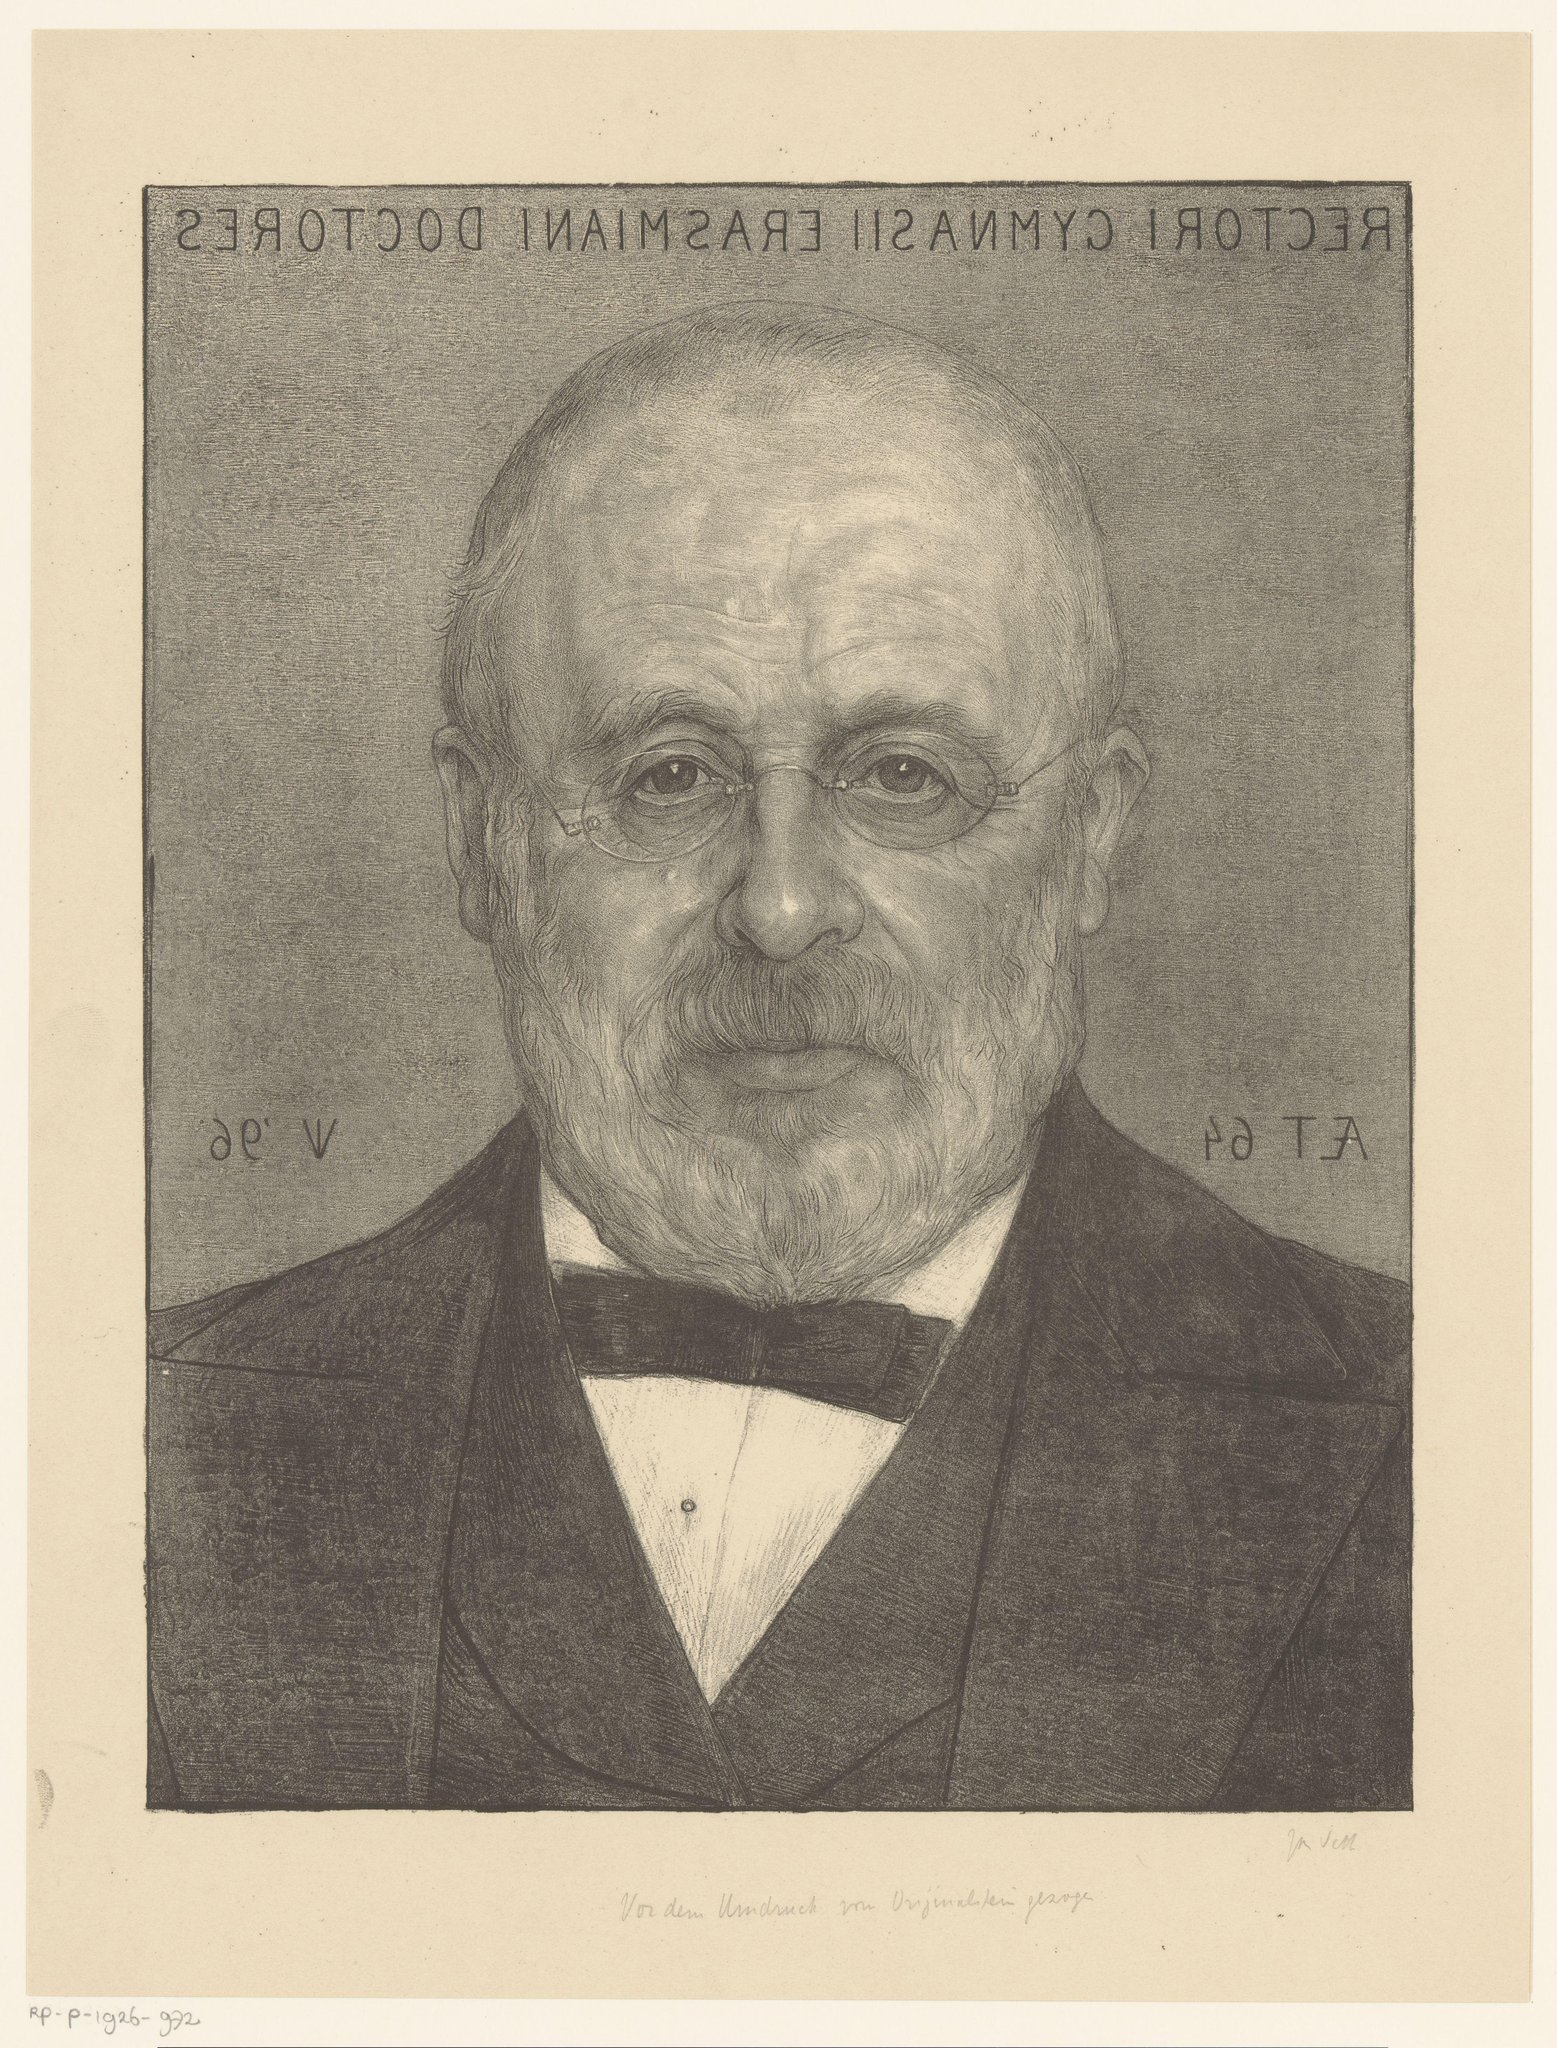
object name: print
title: Portret van Johannes Benedictus Kan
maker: jan veth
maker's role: designer, draughtsman, painter, print maker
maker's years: 1864-1925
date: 1896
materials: paper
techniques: lithograph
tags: historical persons (+ (full) bust portrait)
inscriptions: collector's mark: Lugt 2228, inscription: ‘Vor dem Umdruck von originalstein gezogen’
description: Het opschrift duidt mogelijk op het productieproces waarbij Jan Veth op een steen tekende die vervolgens werd overgezet naar een zogenaamde 'machinesteen' waardoor, middels de snelpers, een hogere oplage gedrukt kon worden.